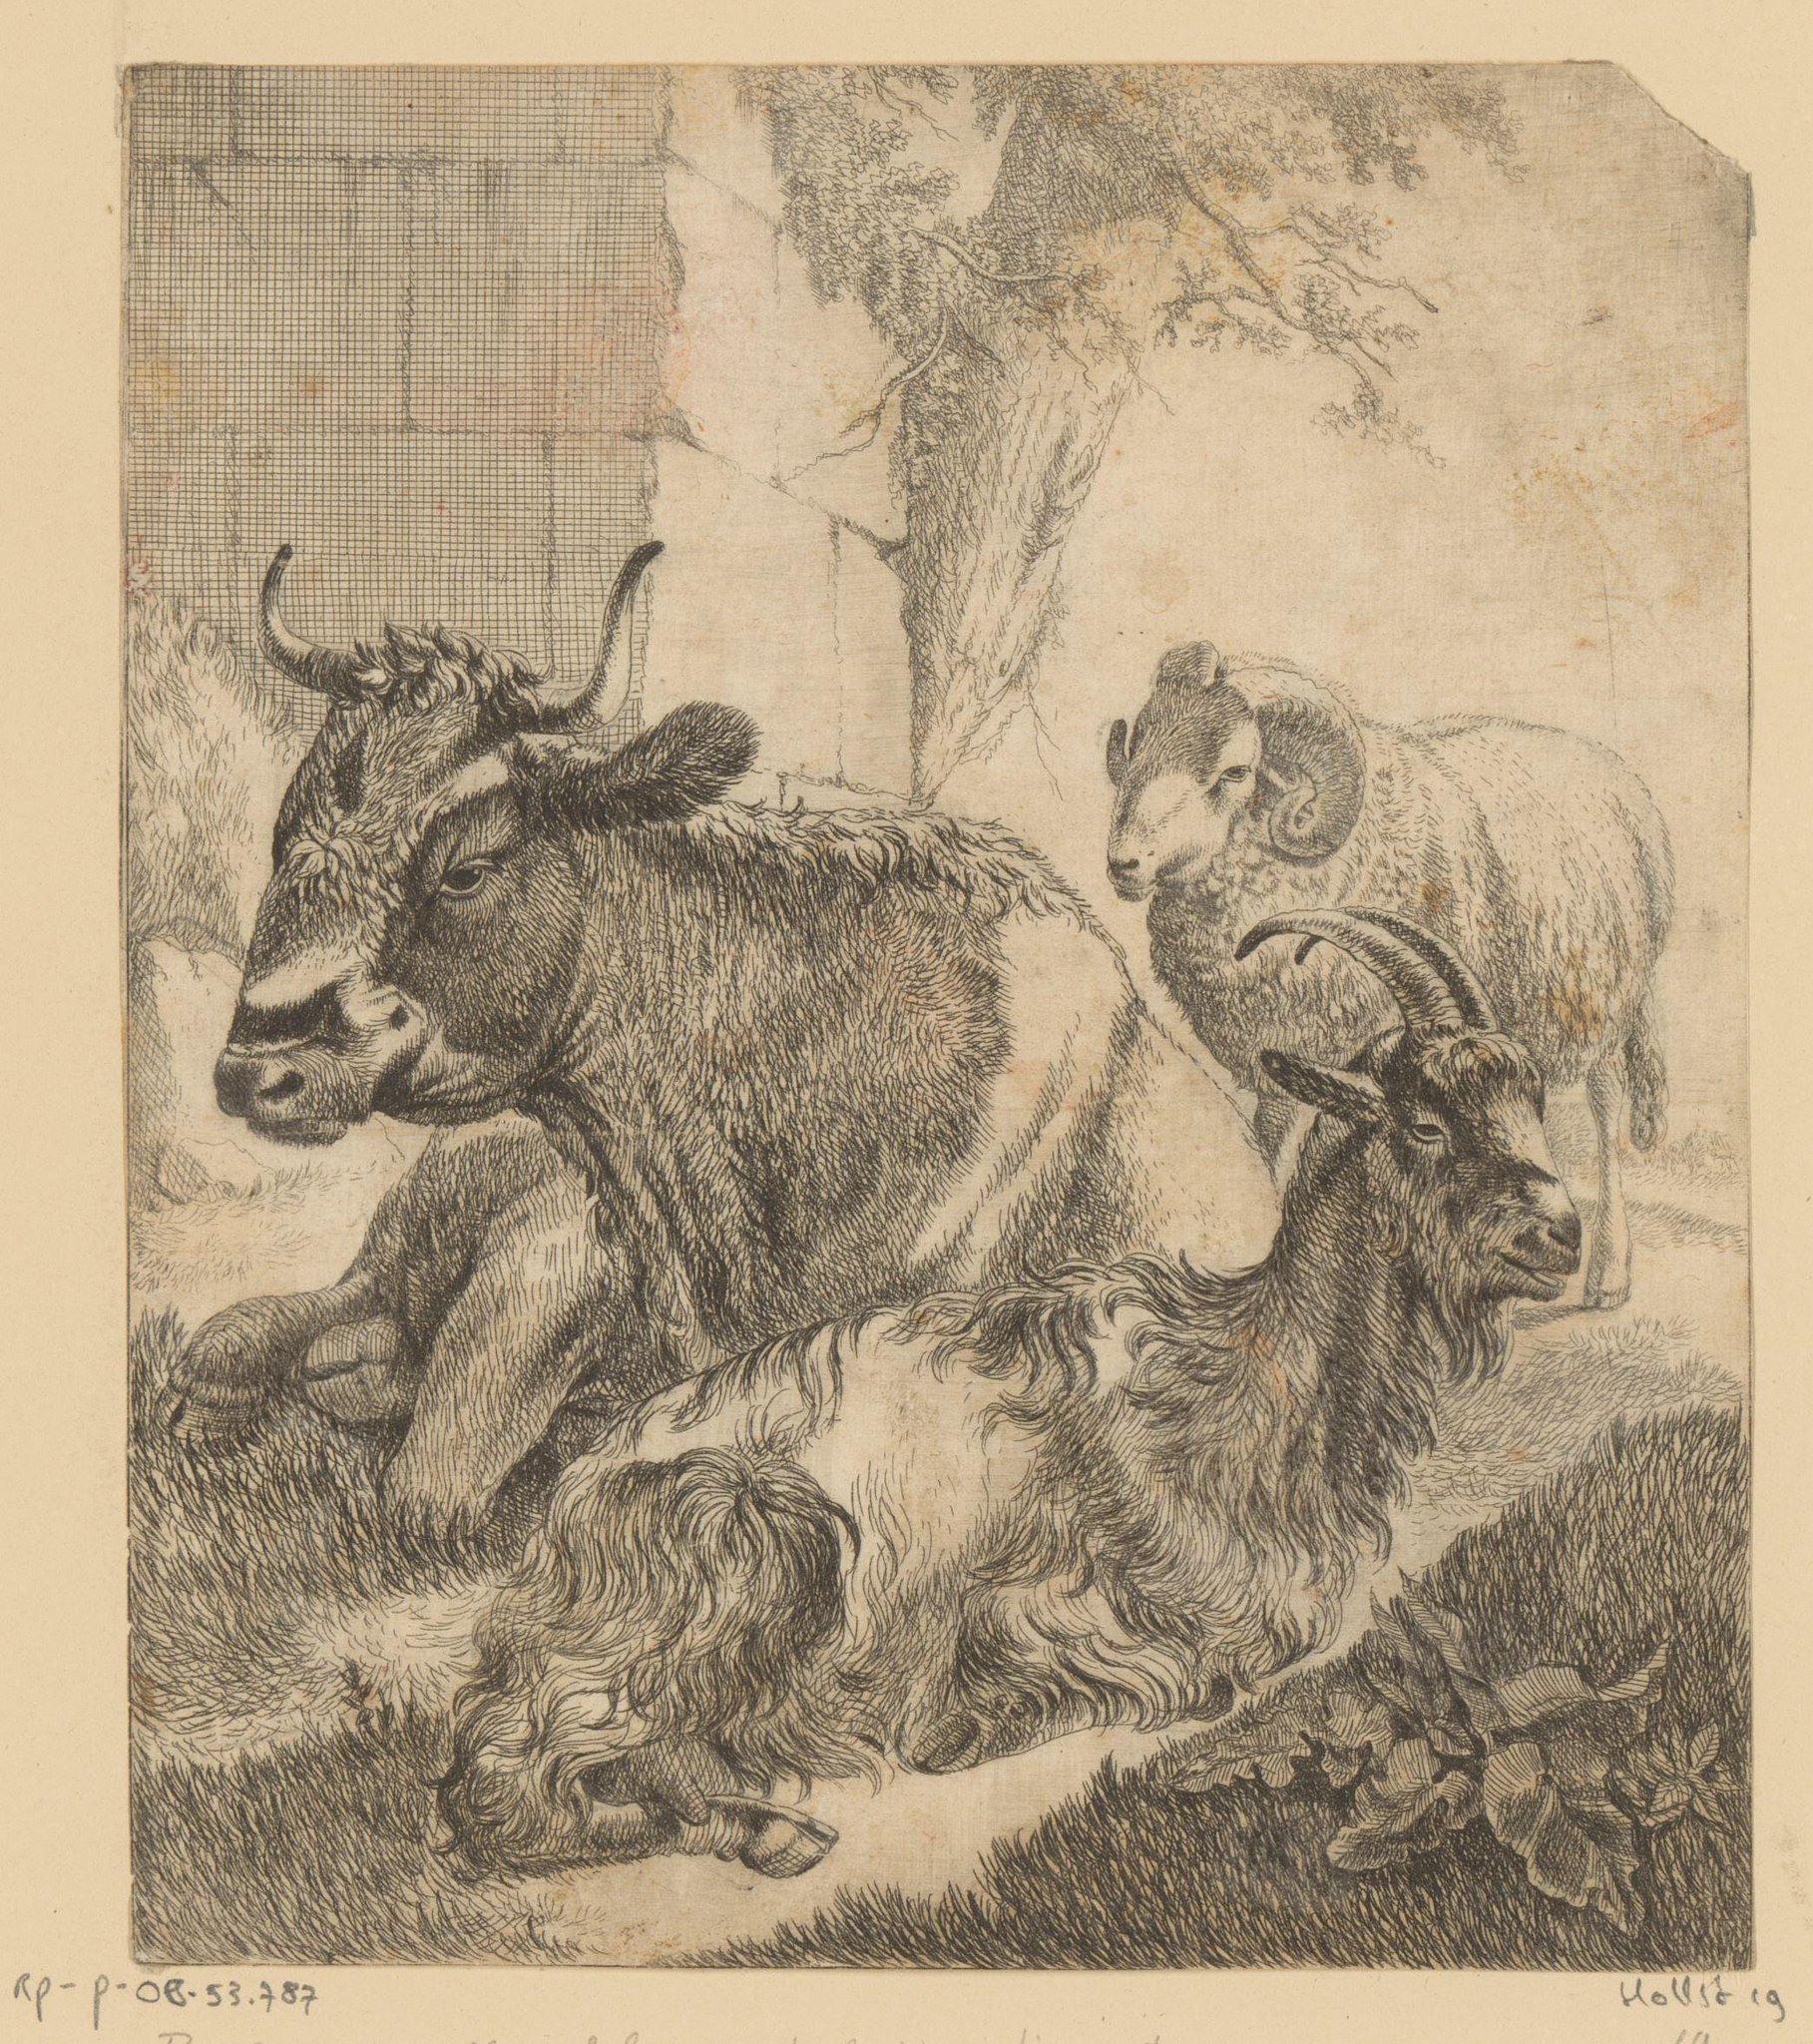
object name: print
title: Schapen, geiten en koeien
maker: johann heinrich roos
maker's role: draughtsman, print maker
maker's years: 1631-1685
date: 1668-1670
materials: paper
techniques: etching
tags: cow, landscapes, ram, goat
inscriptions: collector's mark: Lugt 240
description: Serie van twaalf prenten, waarvan één titelprent.